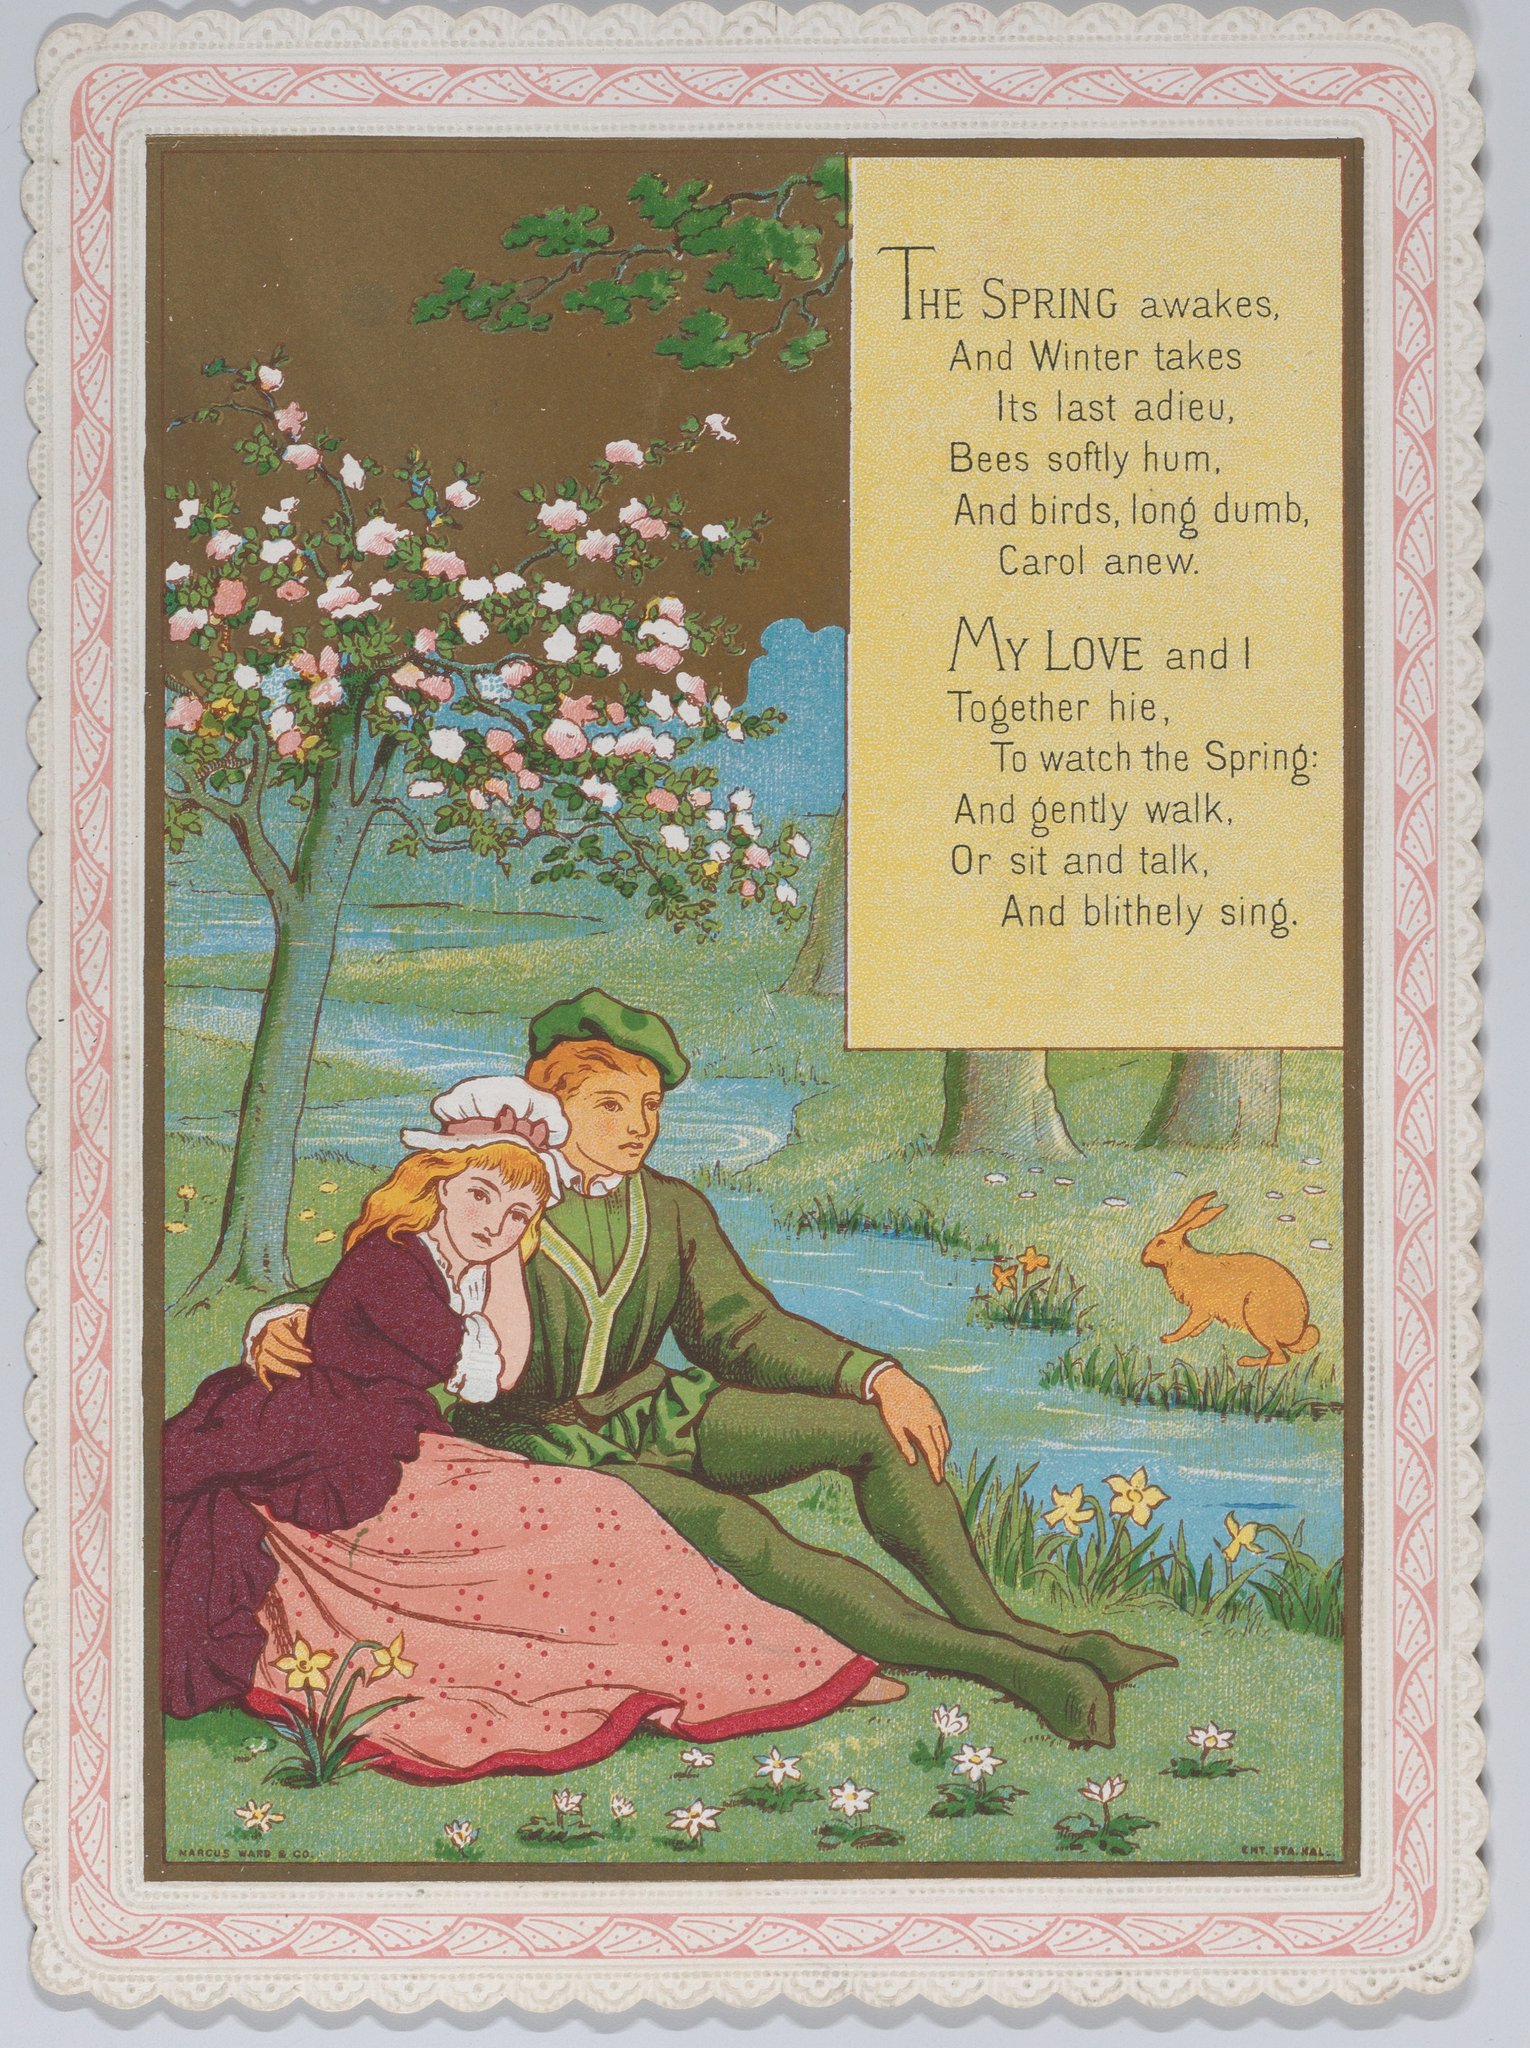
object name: valentine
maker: kate greenaway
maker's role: artist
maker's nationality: british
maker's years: 1846-1901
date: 1874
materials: gilt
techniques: chromolithography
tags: poetry,men,women,rabbits